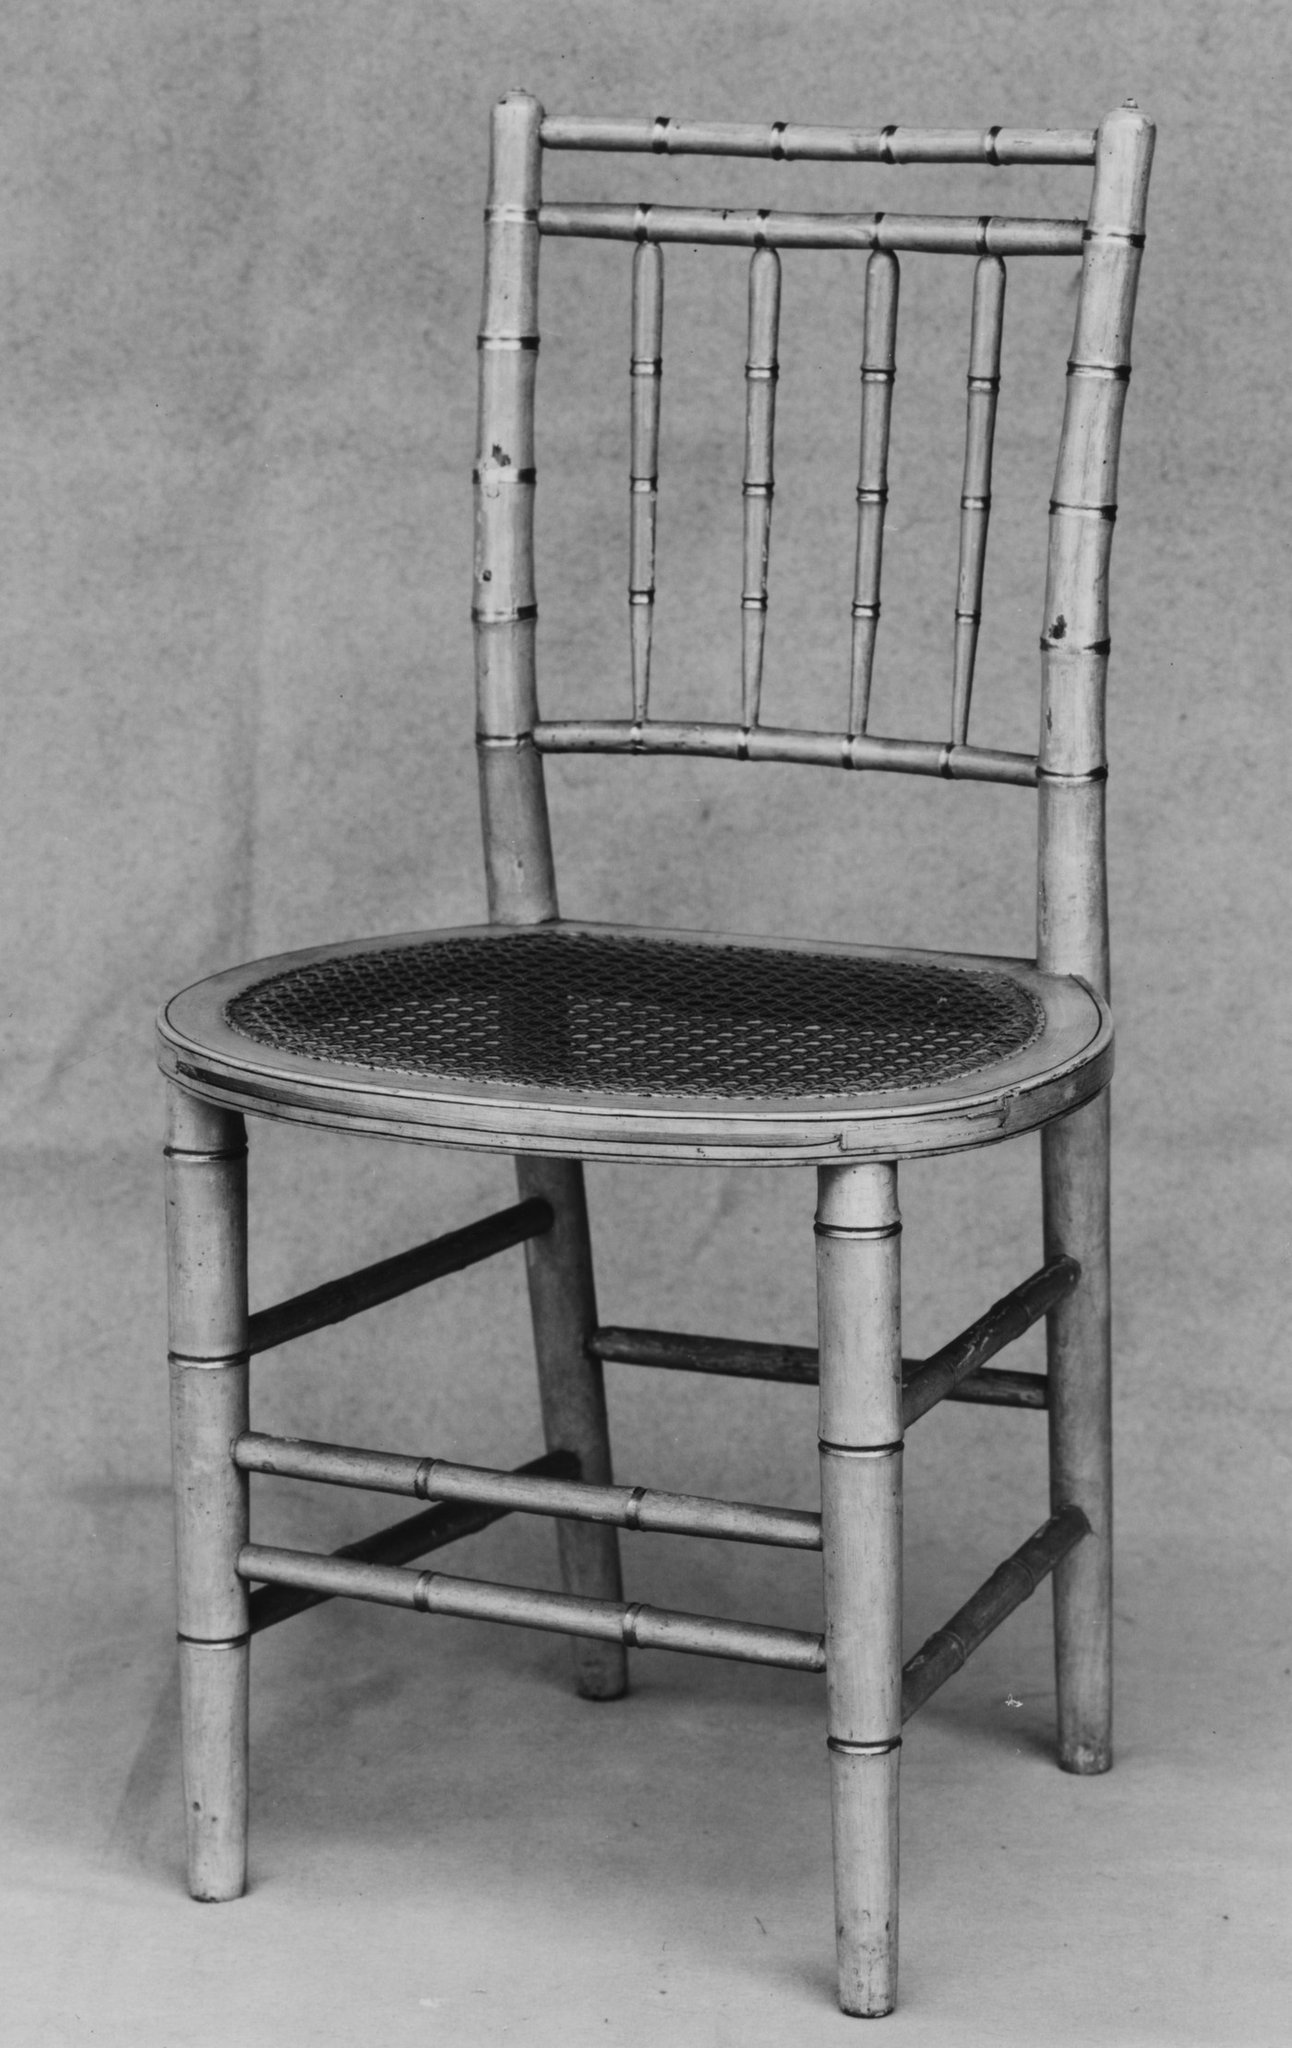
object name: side chair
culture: american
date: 1800-1830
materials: wood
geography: united states